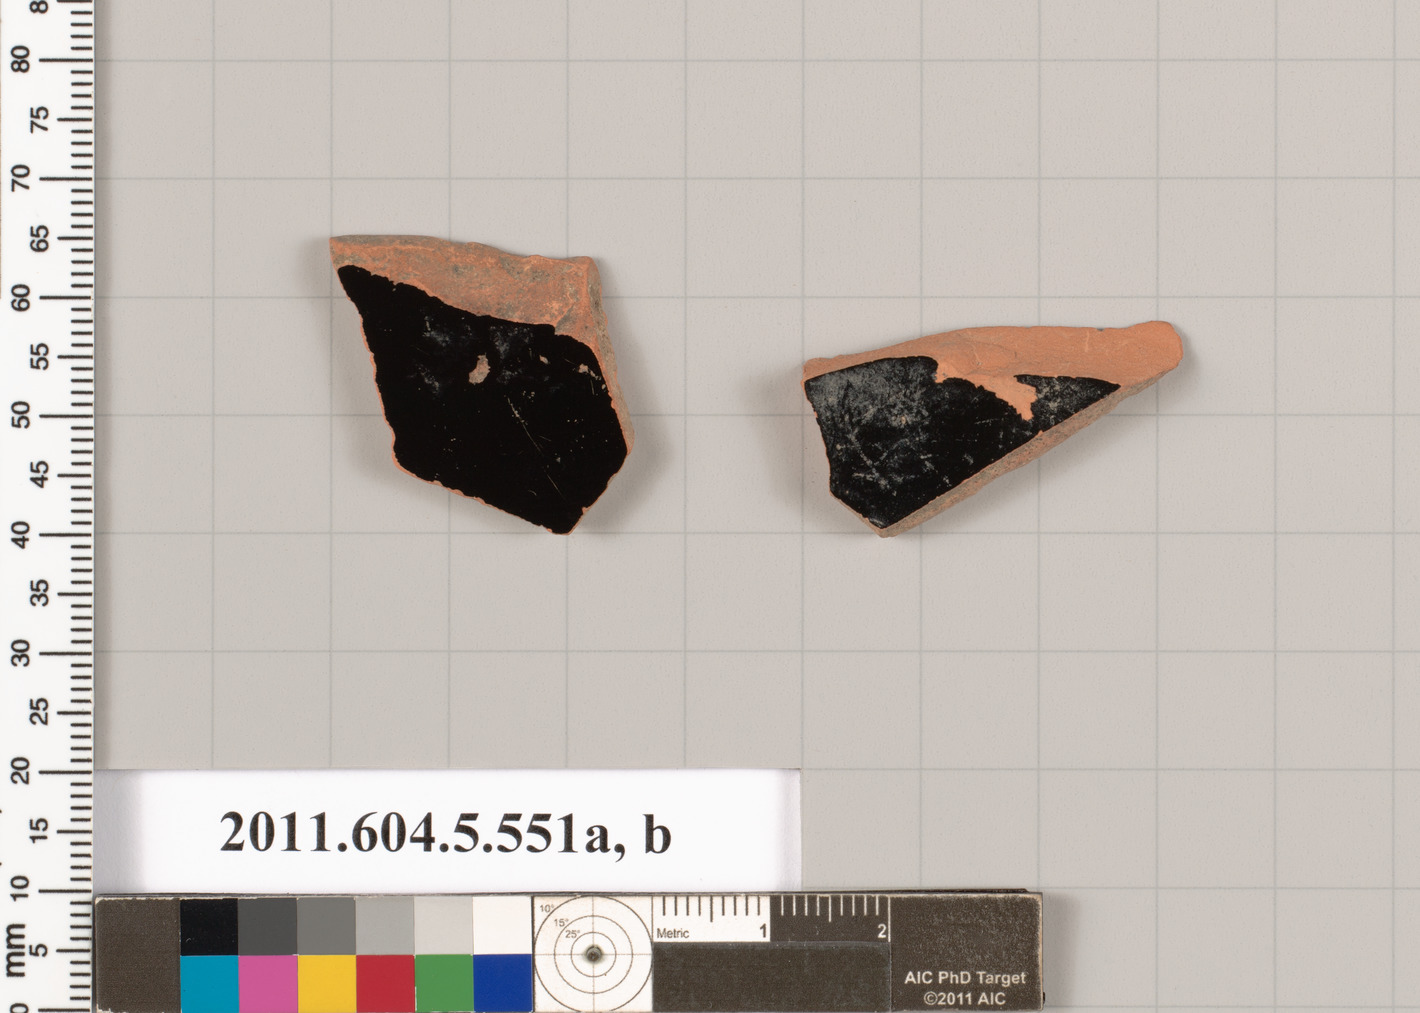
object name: kylix fragment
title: Terracotta fragments of kylikes (drinking cups)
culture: greek, attic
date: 600-401 BCE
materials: terracotta